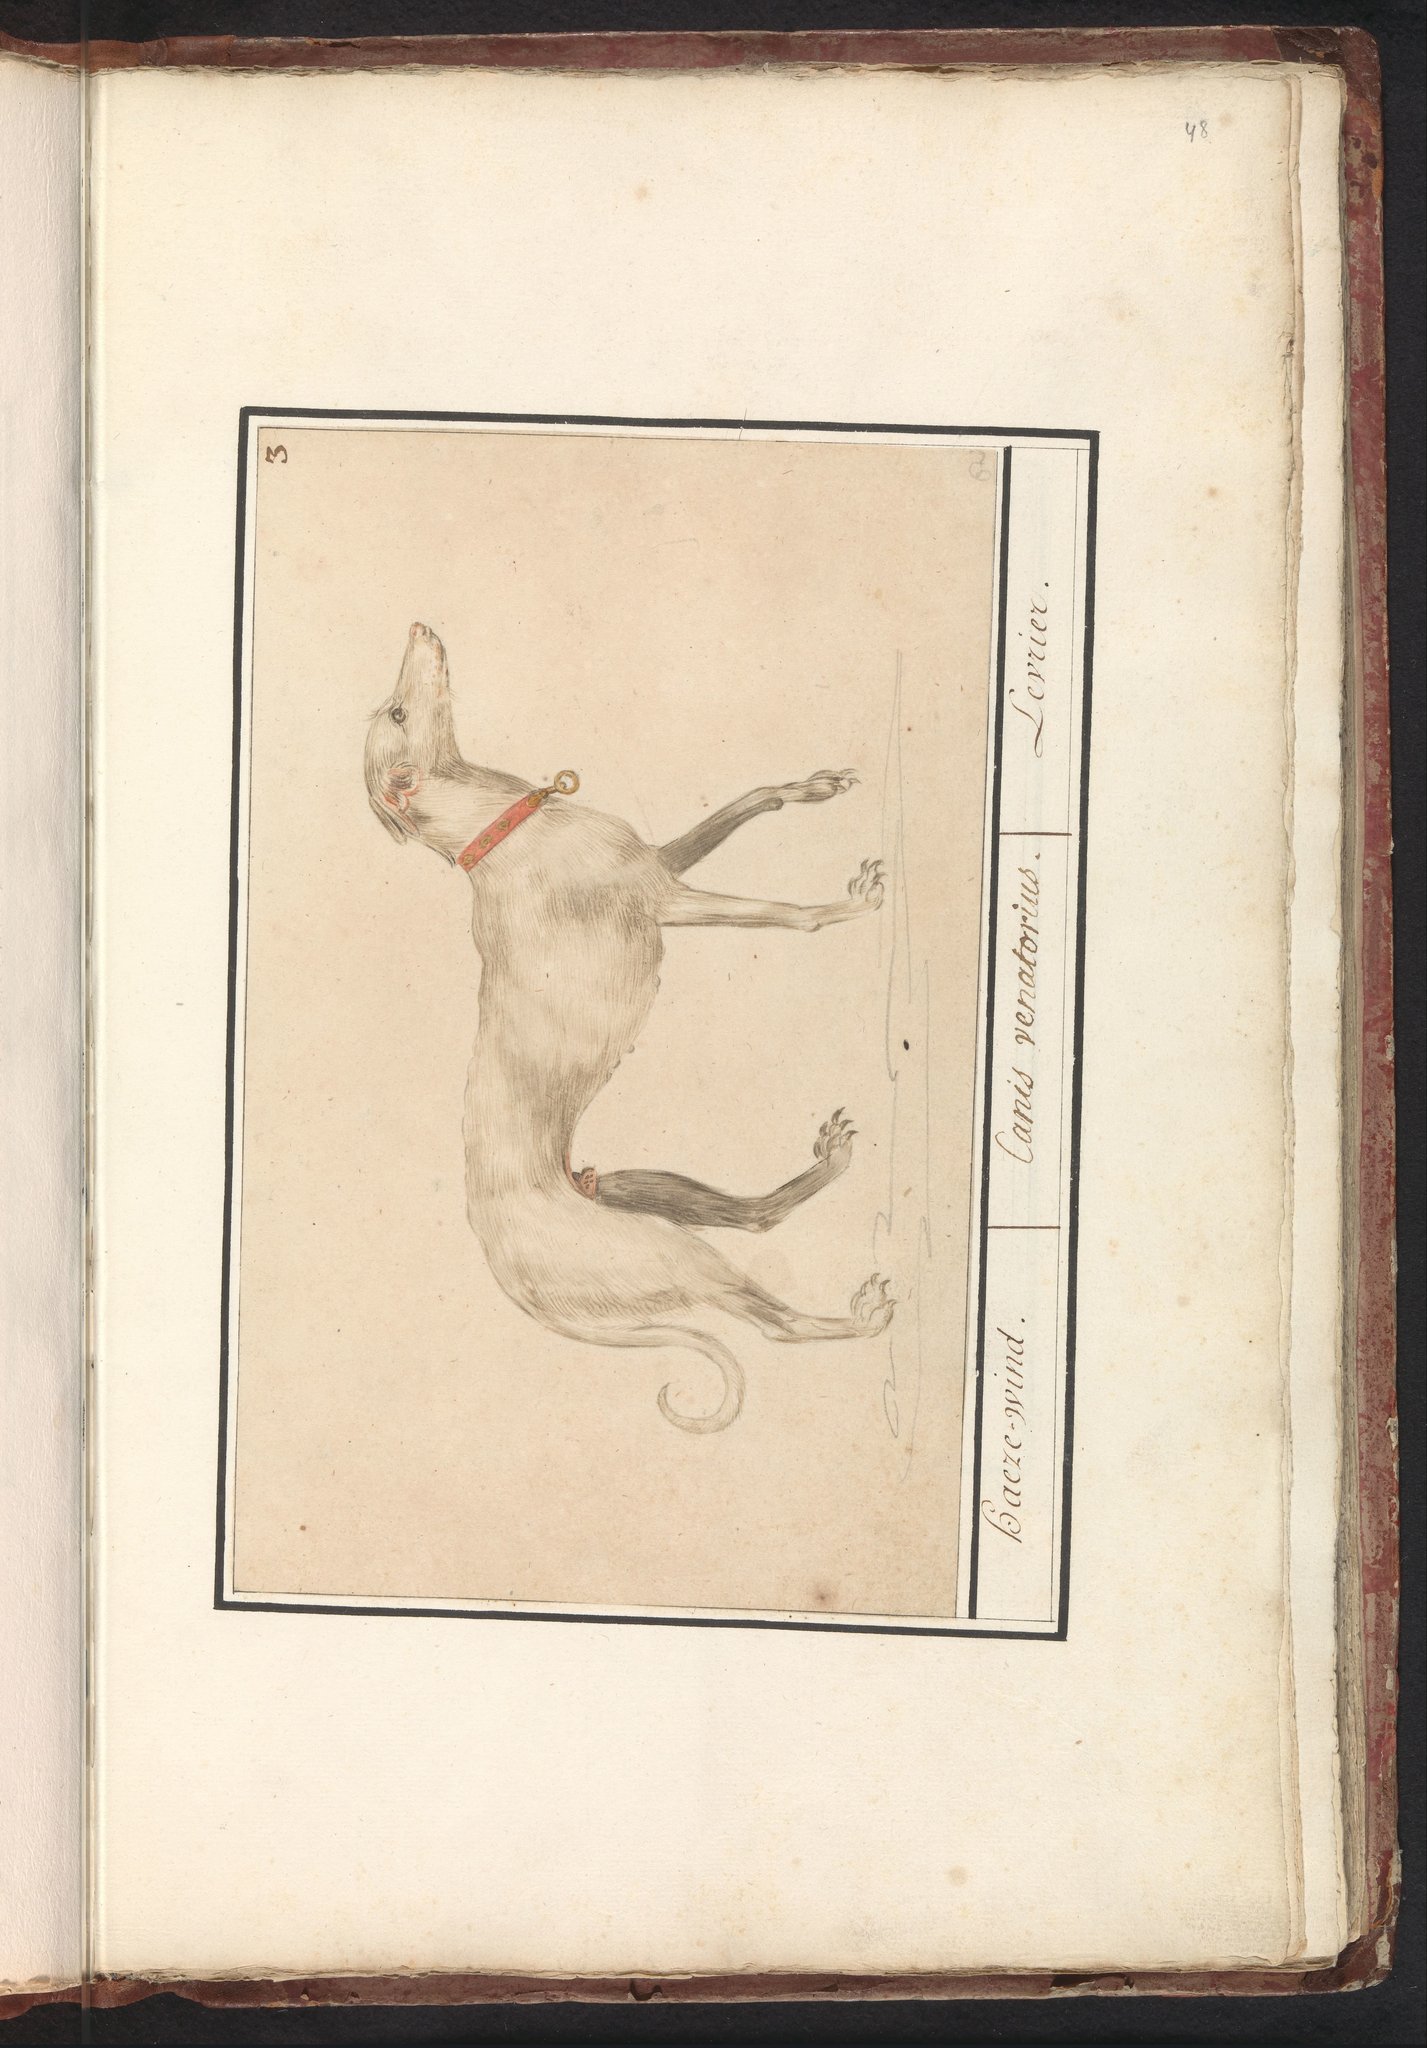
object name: drawing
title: Sighthound (Canis lupus familiaris)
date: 1596-1610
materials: paper, pencil, watercolor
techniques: brush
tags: dog (with name of kind)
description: De Boodt could study many live animals from far-flung places in Rudolf II’s menagerie, as well as numerous stuffed creatures in his Kunstkammer (cabinet of curiosities). Even so, many drawings in De Boodt’s albums were not made from direct observation of nature, but ‘borrowed’ from illustrations by other artists. The red collar of this sighthound indicates that the animal was probably drawn from life.